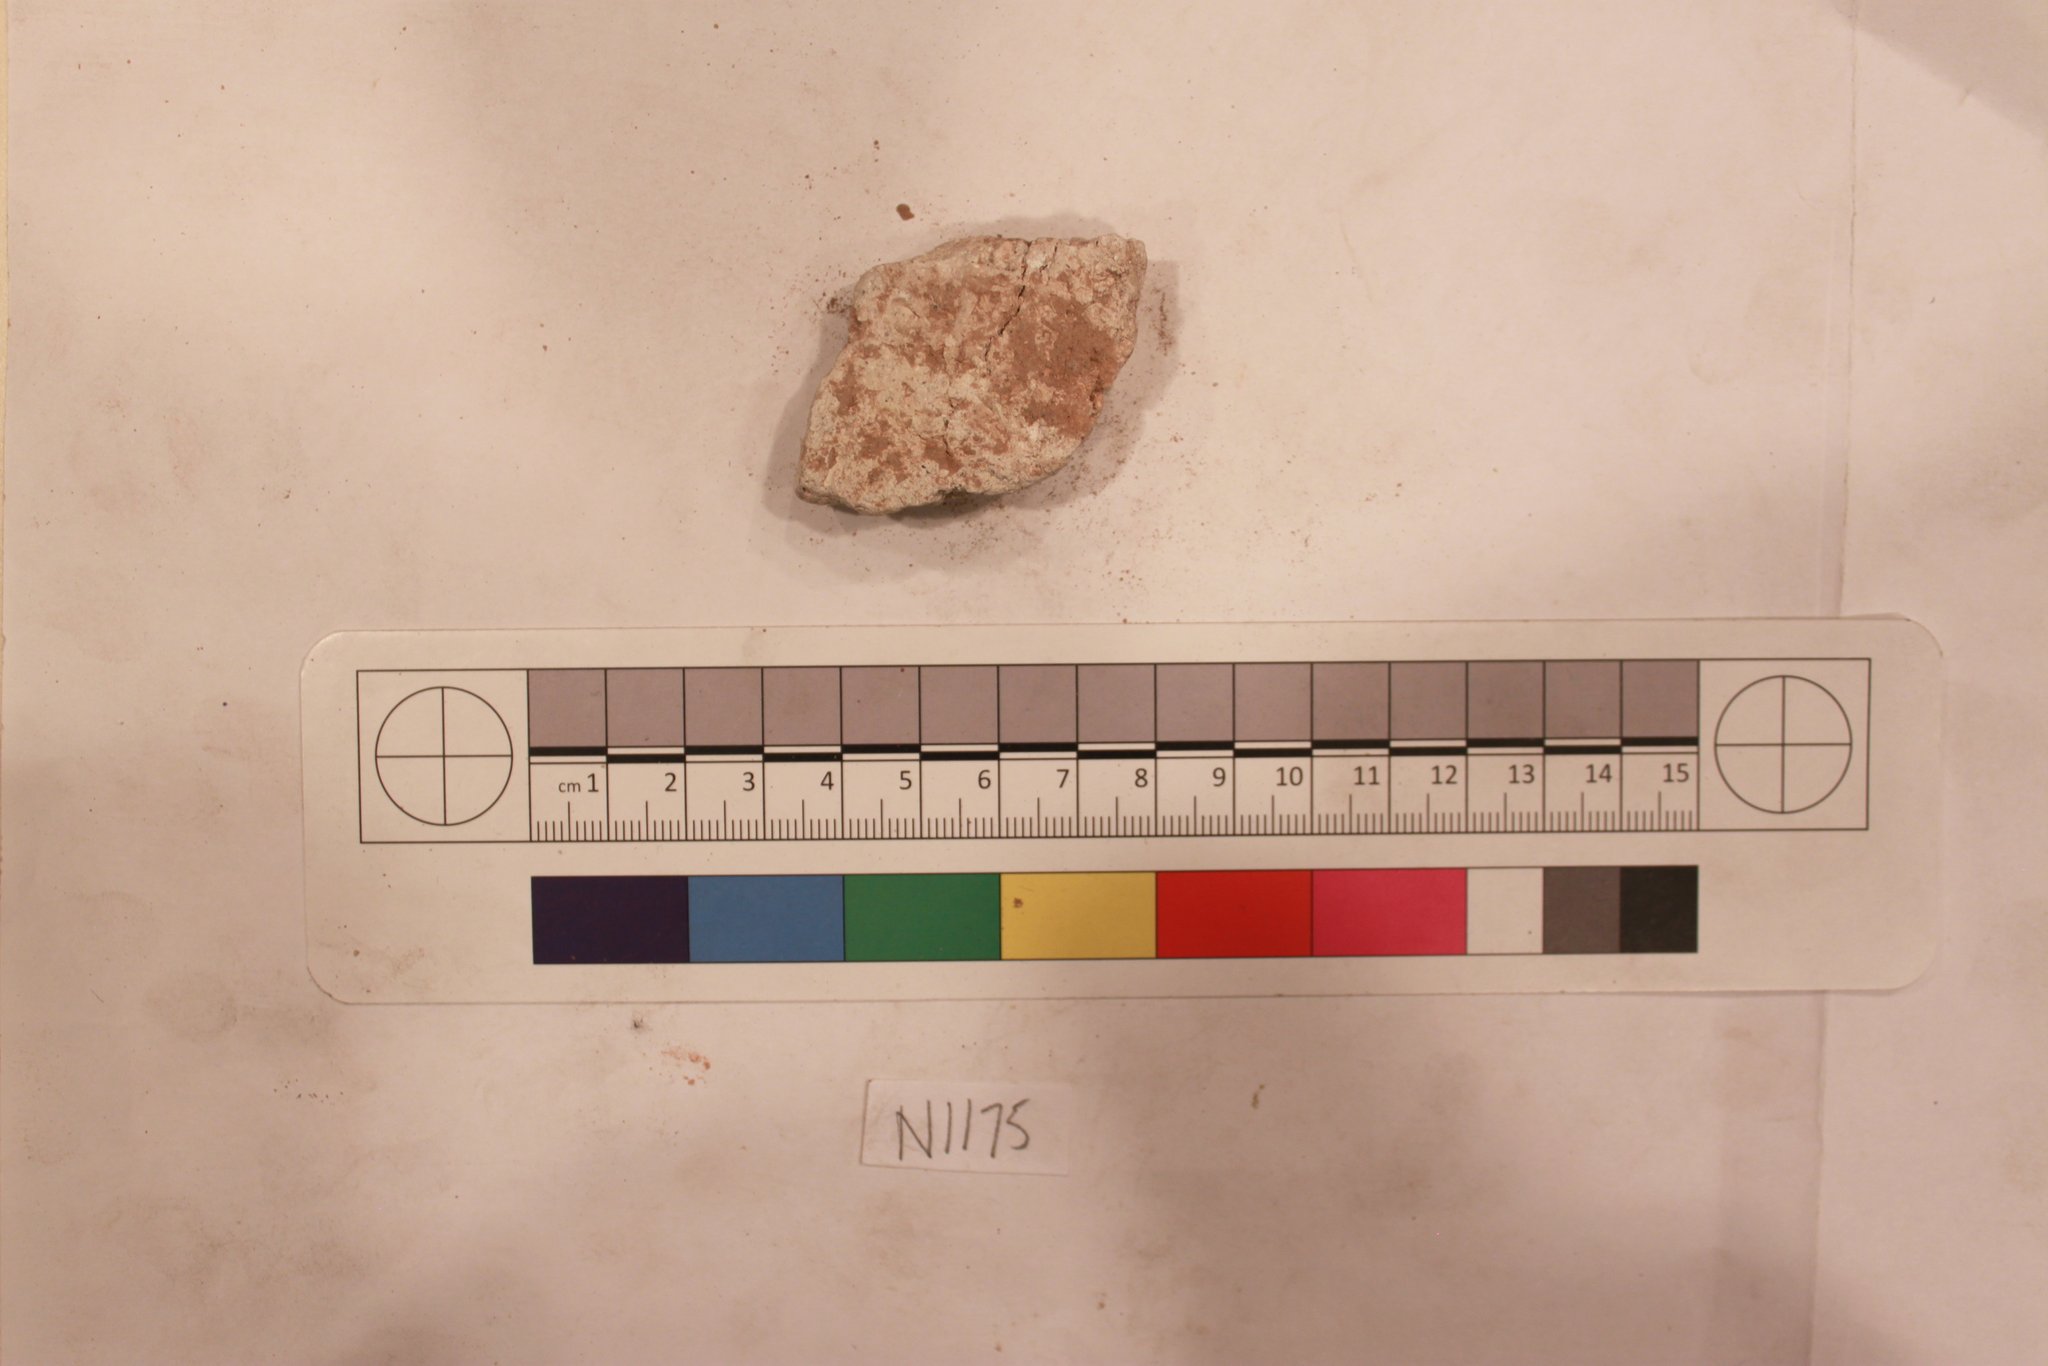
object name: fragment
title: Stucco Fragment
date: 701-1200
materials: plaster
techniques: carving, painting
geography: iran